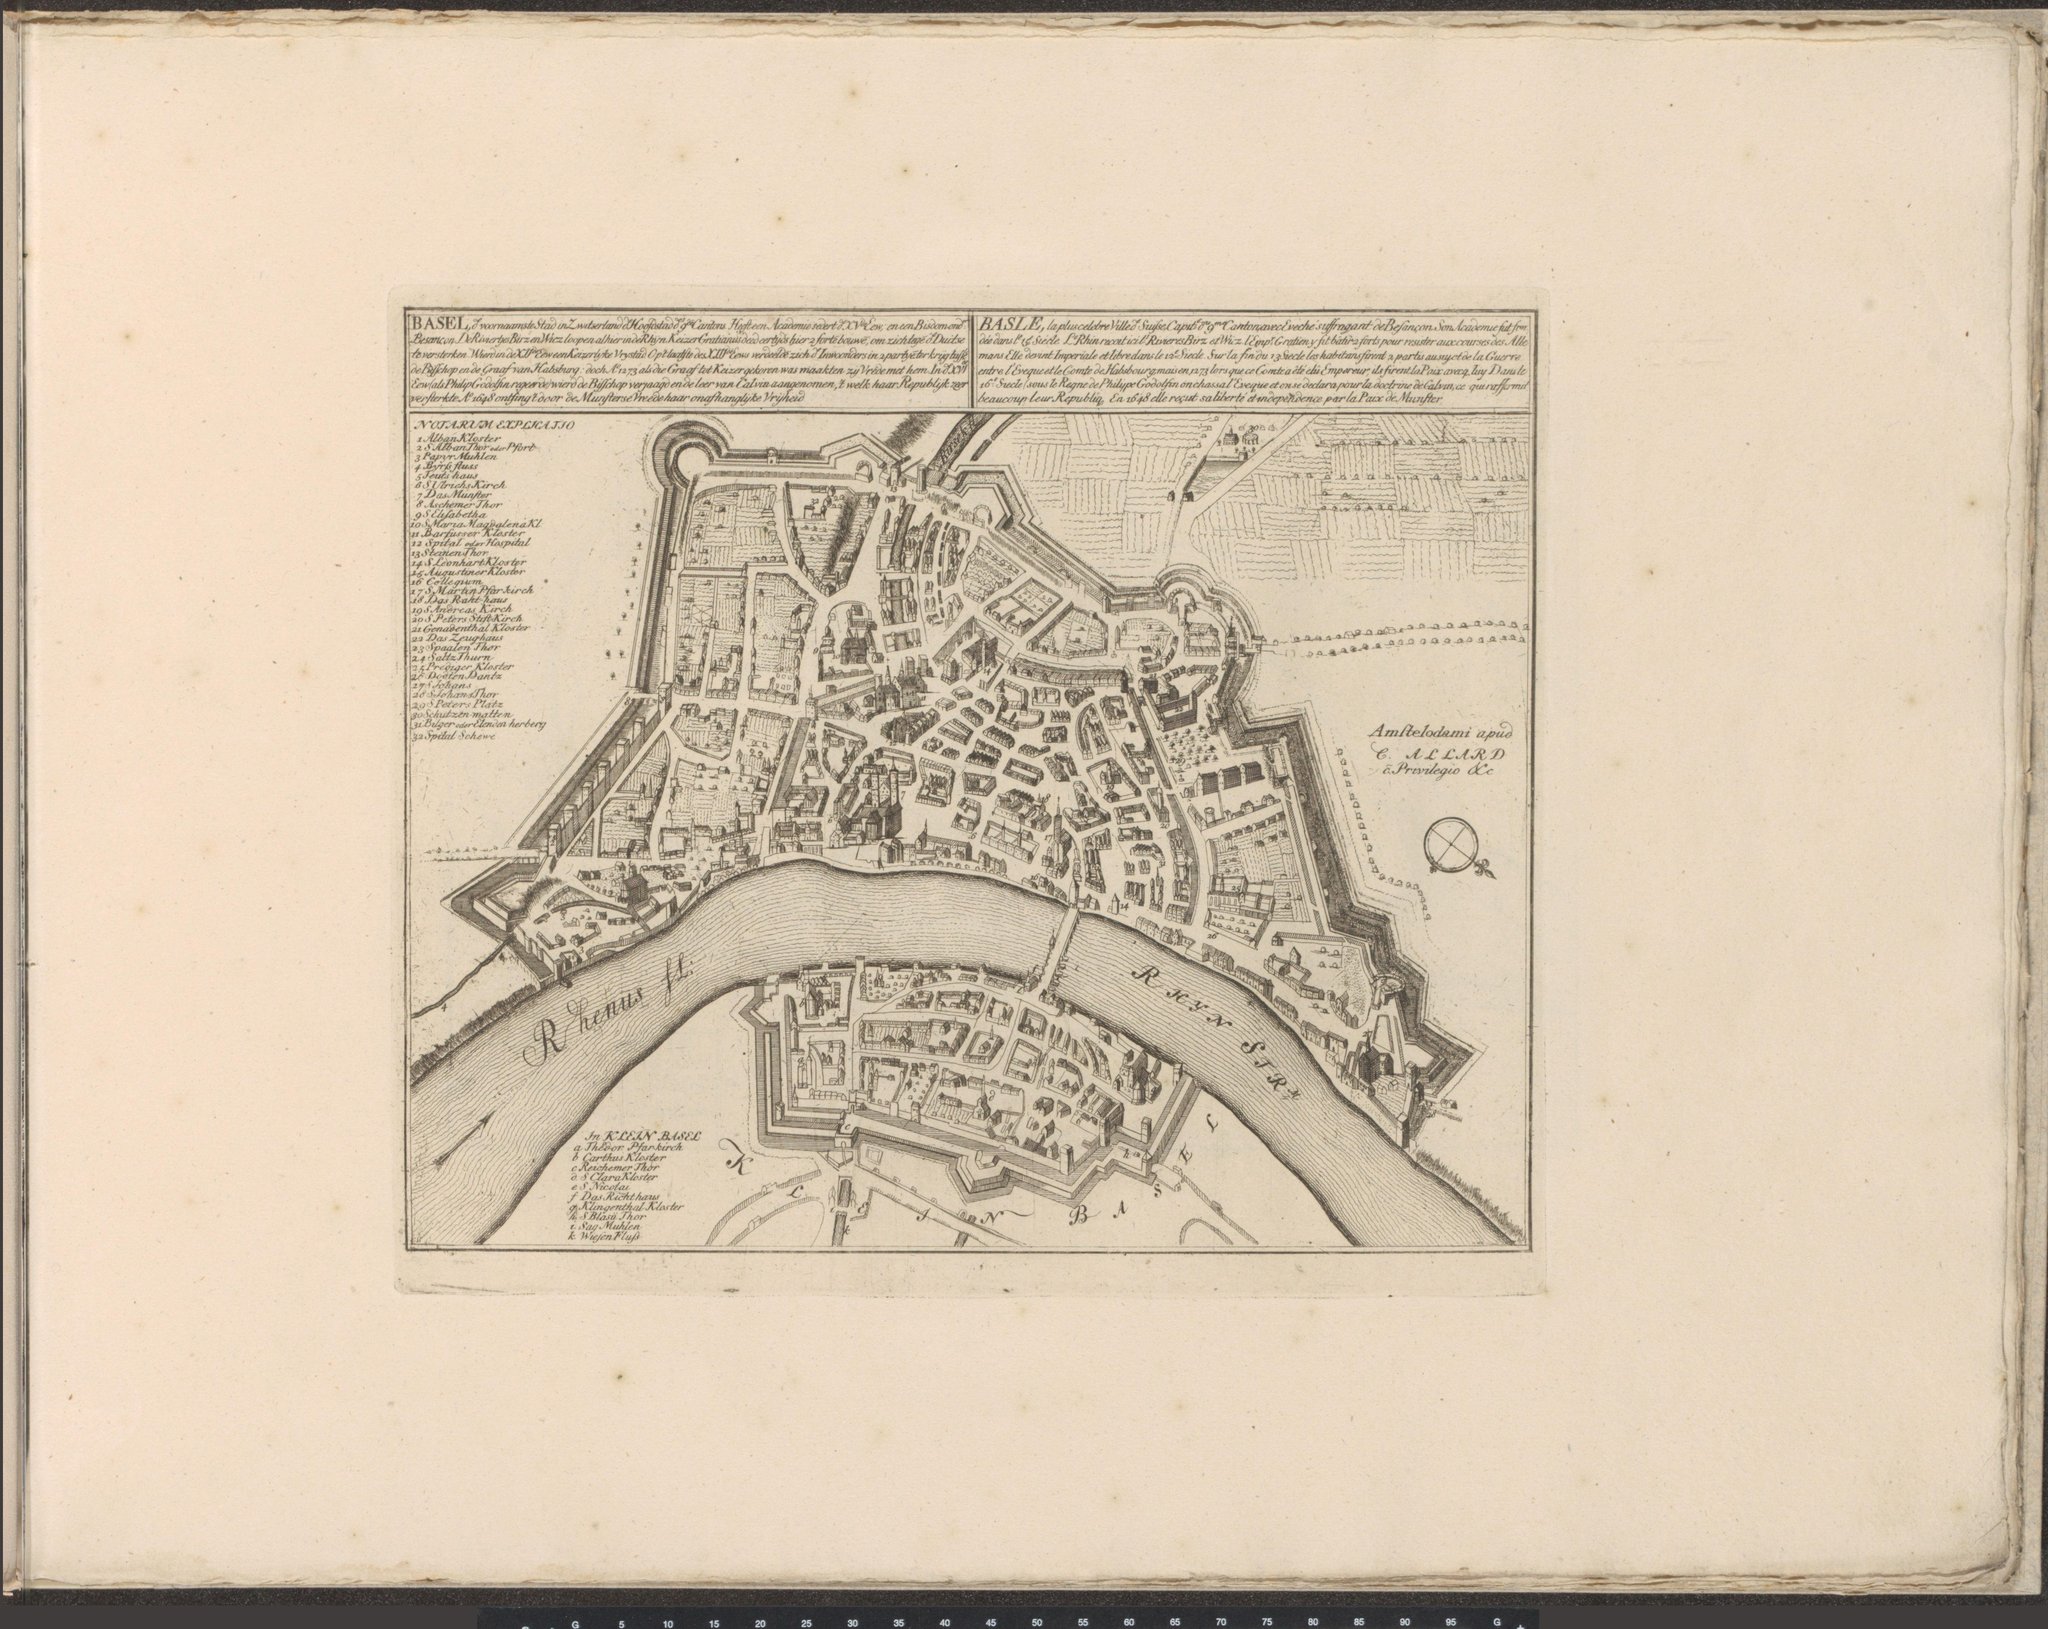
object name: album leaf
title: Les Principales Forteresses & Villes Fortes, d'Espagne, de France, d'Italie, de Savoië, d'Allemagne & des Païs-Bas (...) / Naaukeurige Afbeeldingen der Voornaamste Sterke Steden en Vestingen in Spanjen, Vrankryk, Italien, Savoyen, Duytsland en Nederlanden (...)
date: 1701-1733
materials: paper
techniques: etching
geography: amsterdam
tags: maps of cities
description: Plattegrond van de Zwitserse stad Bazel (Basel), gelegen aan de Rijn. Met teksten in het Nederlands en Frans. De prent maakt deel uit van een album.